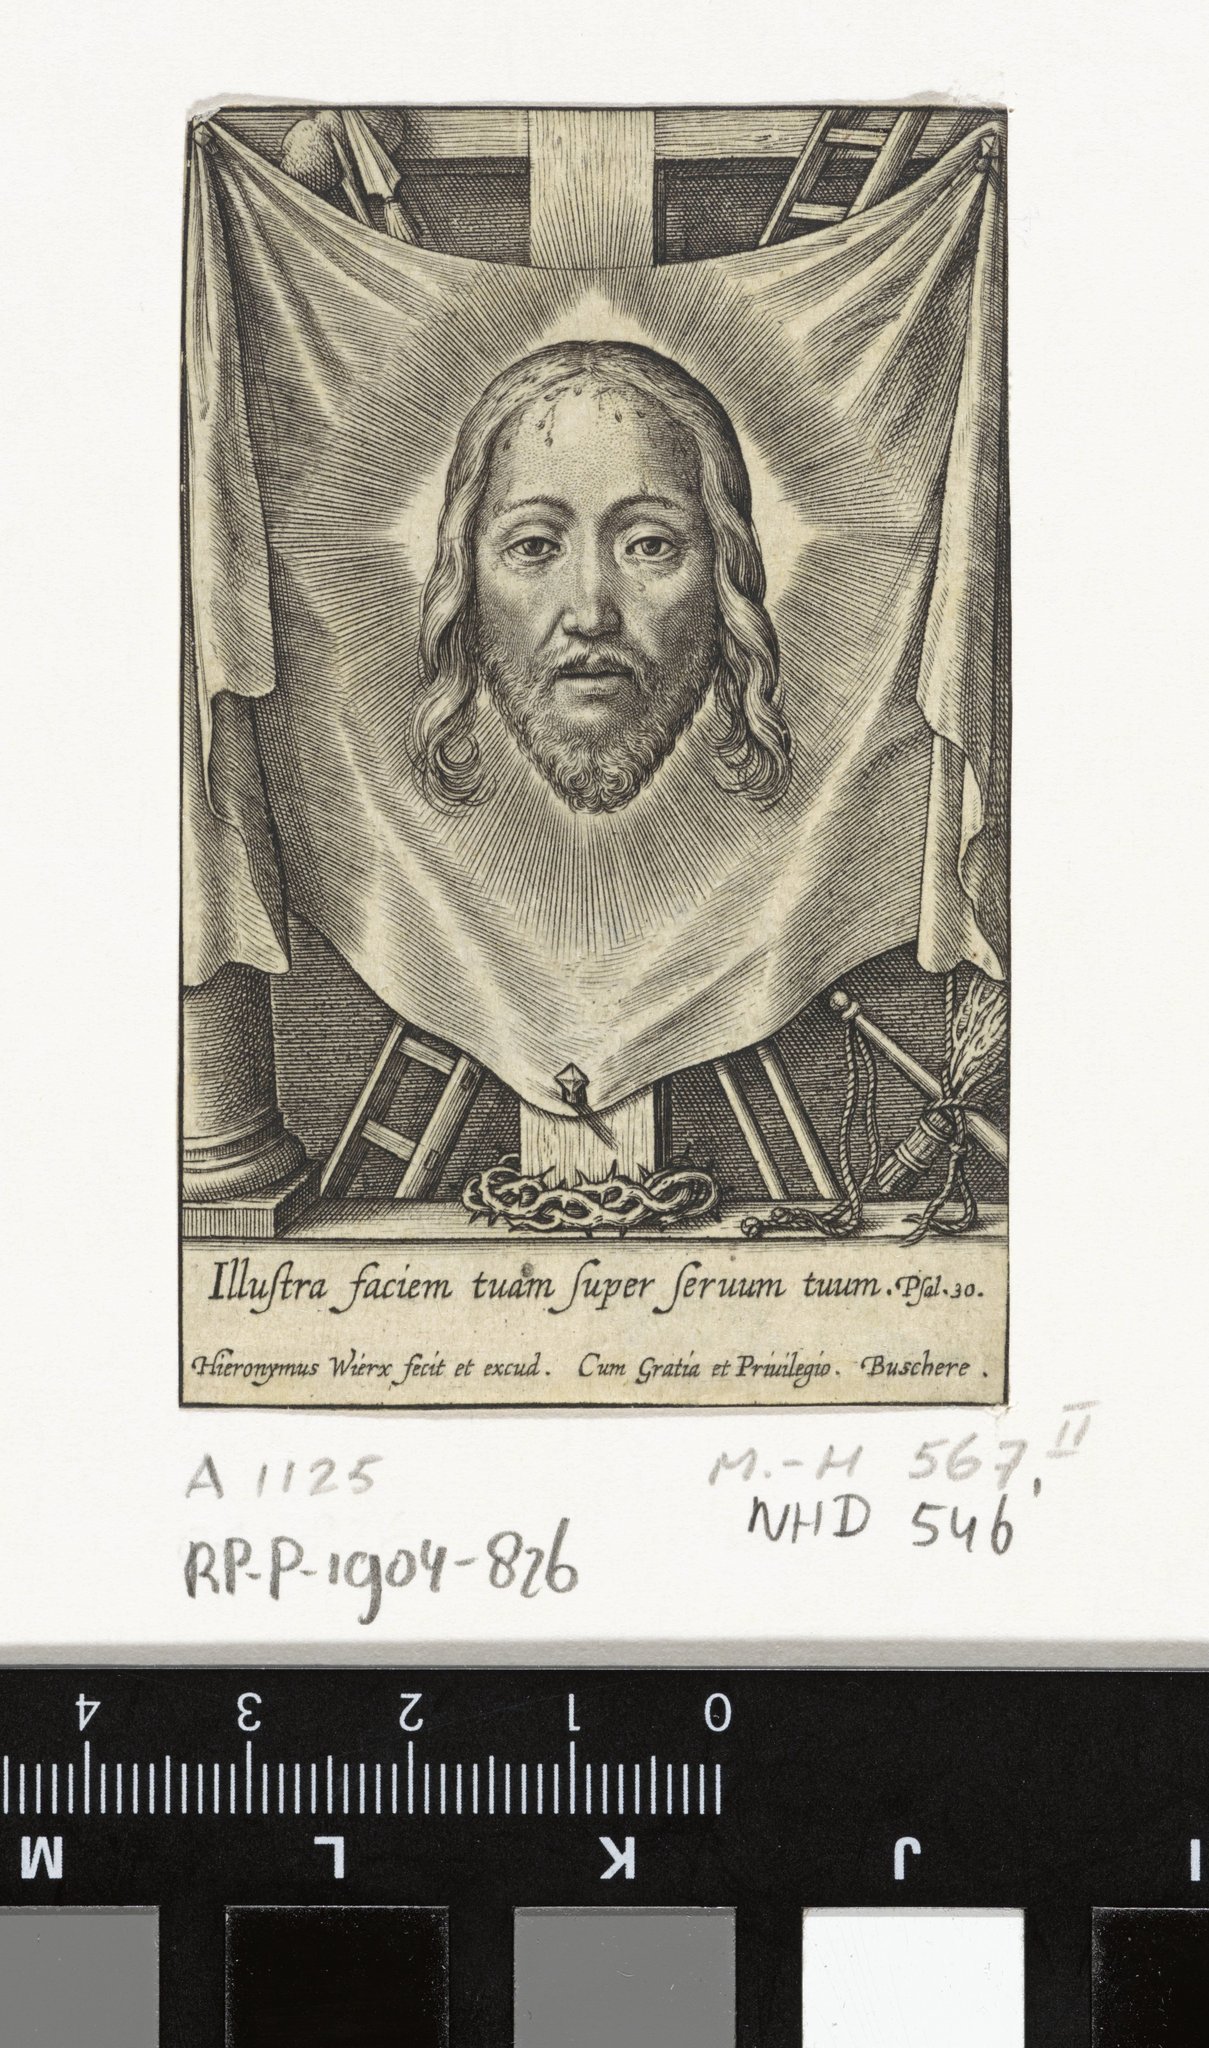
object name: print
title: Heilige sudarium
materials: paper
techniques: engraving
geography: antwerp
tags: single instruments of the passion, 'vera icon', 'sudarium', veronica-portrait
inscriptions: collector's mark: Lugt 2228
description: De zweetdoek van Veronica, waar een afdruk van Christus' gelaat op staat, hangt aan het kruis. Rondom de doek verschillende passiewerktuigen. In de marge een Bijbelcitaat uit Ps. 30 in het Latijn.